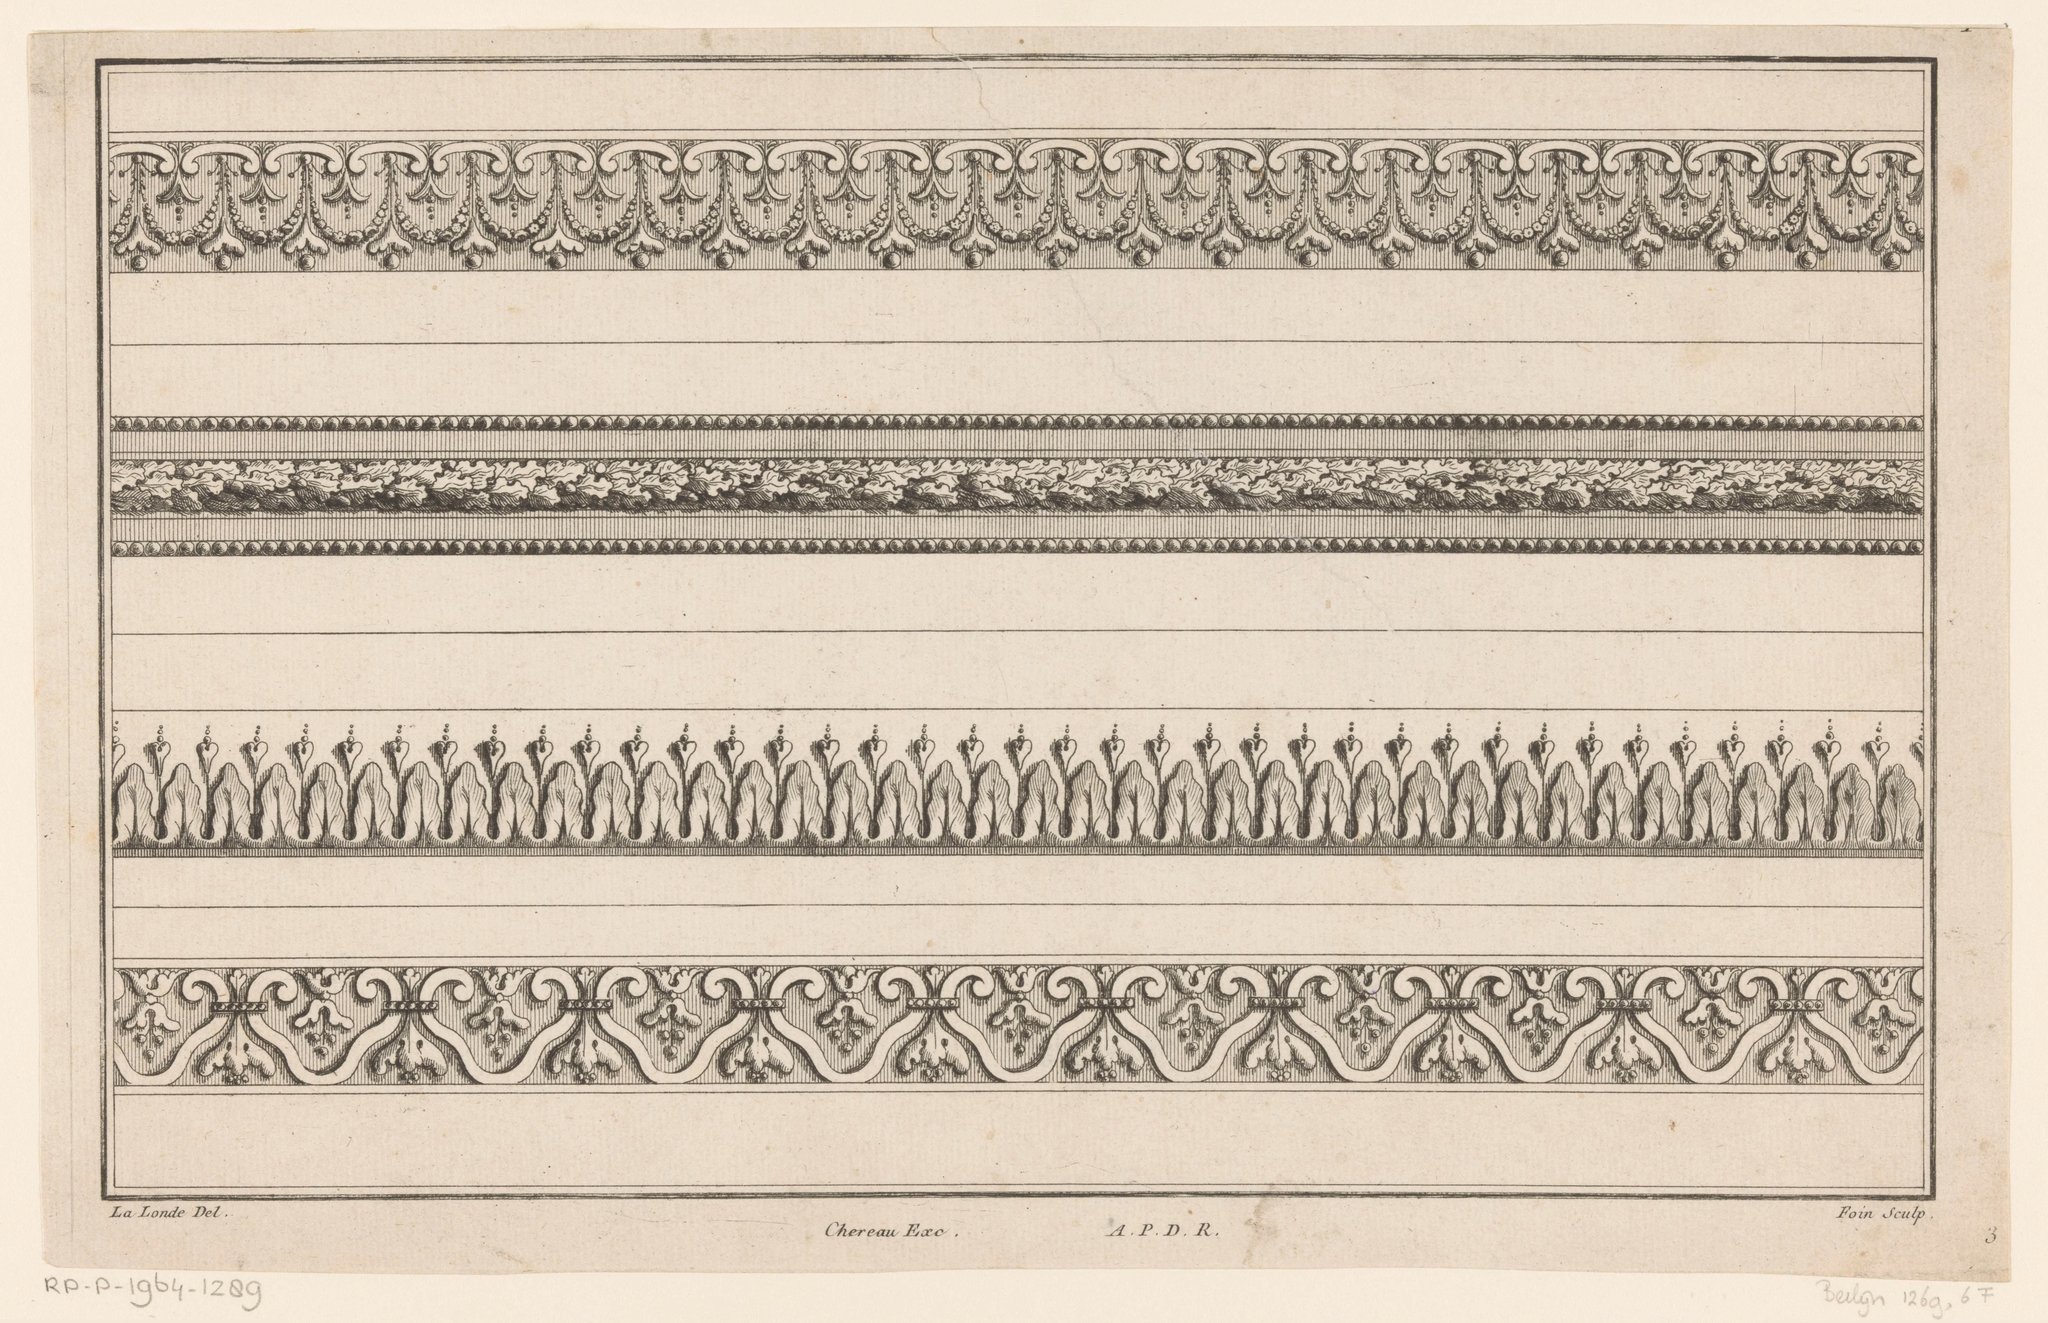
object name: ornament print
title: Vier randen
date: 1784-1785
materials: paper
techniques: engraving, etching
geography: paris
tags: ornaments ~ art (+ framing decorations)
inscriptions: collector's mark: Lugt 2760, collector's mark: Lugt 2228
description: Vier geornamenteerde randen met vlechtwerk en bladmotieven.